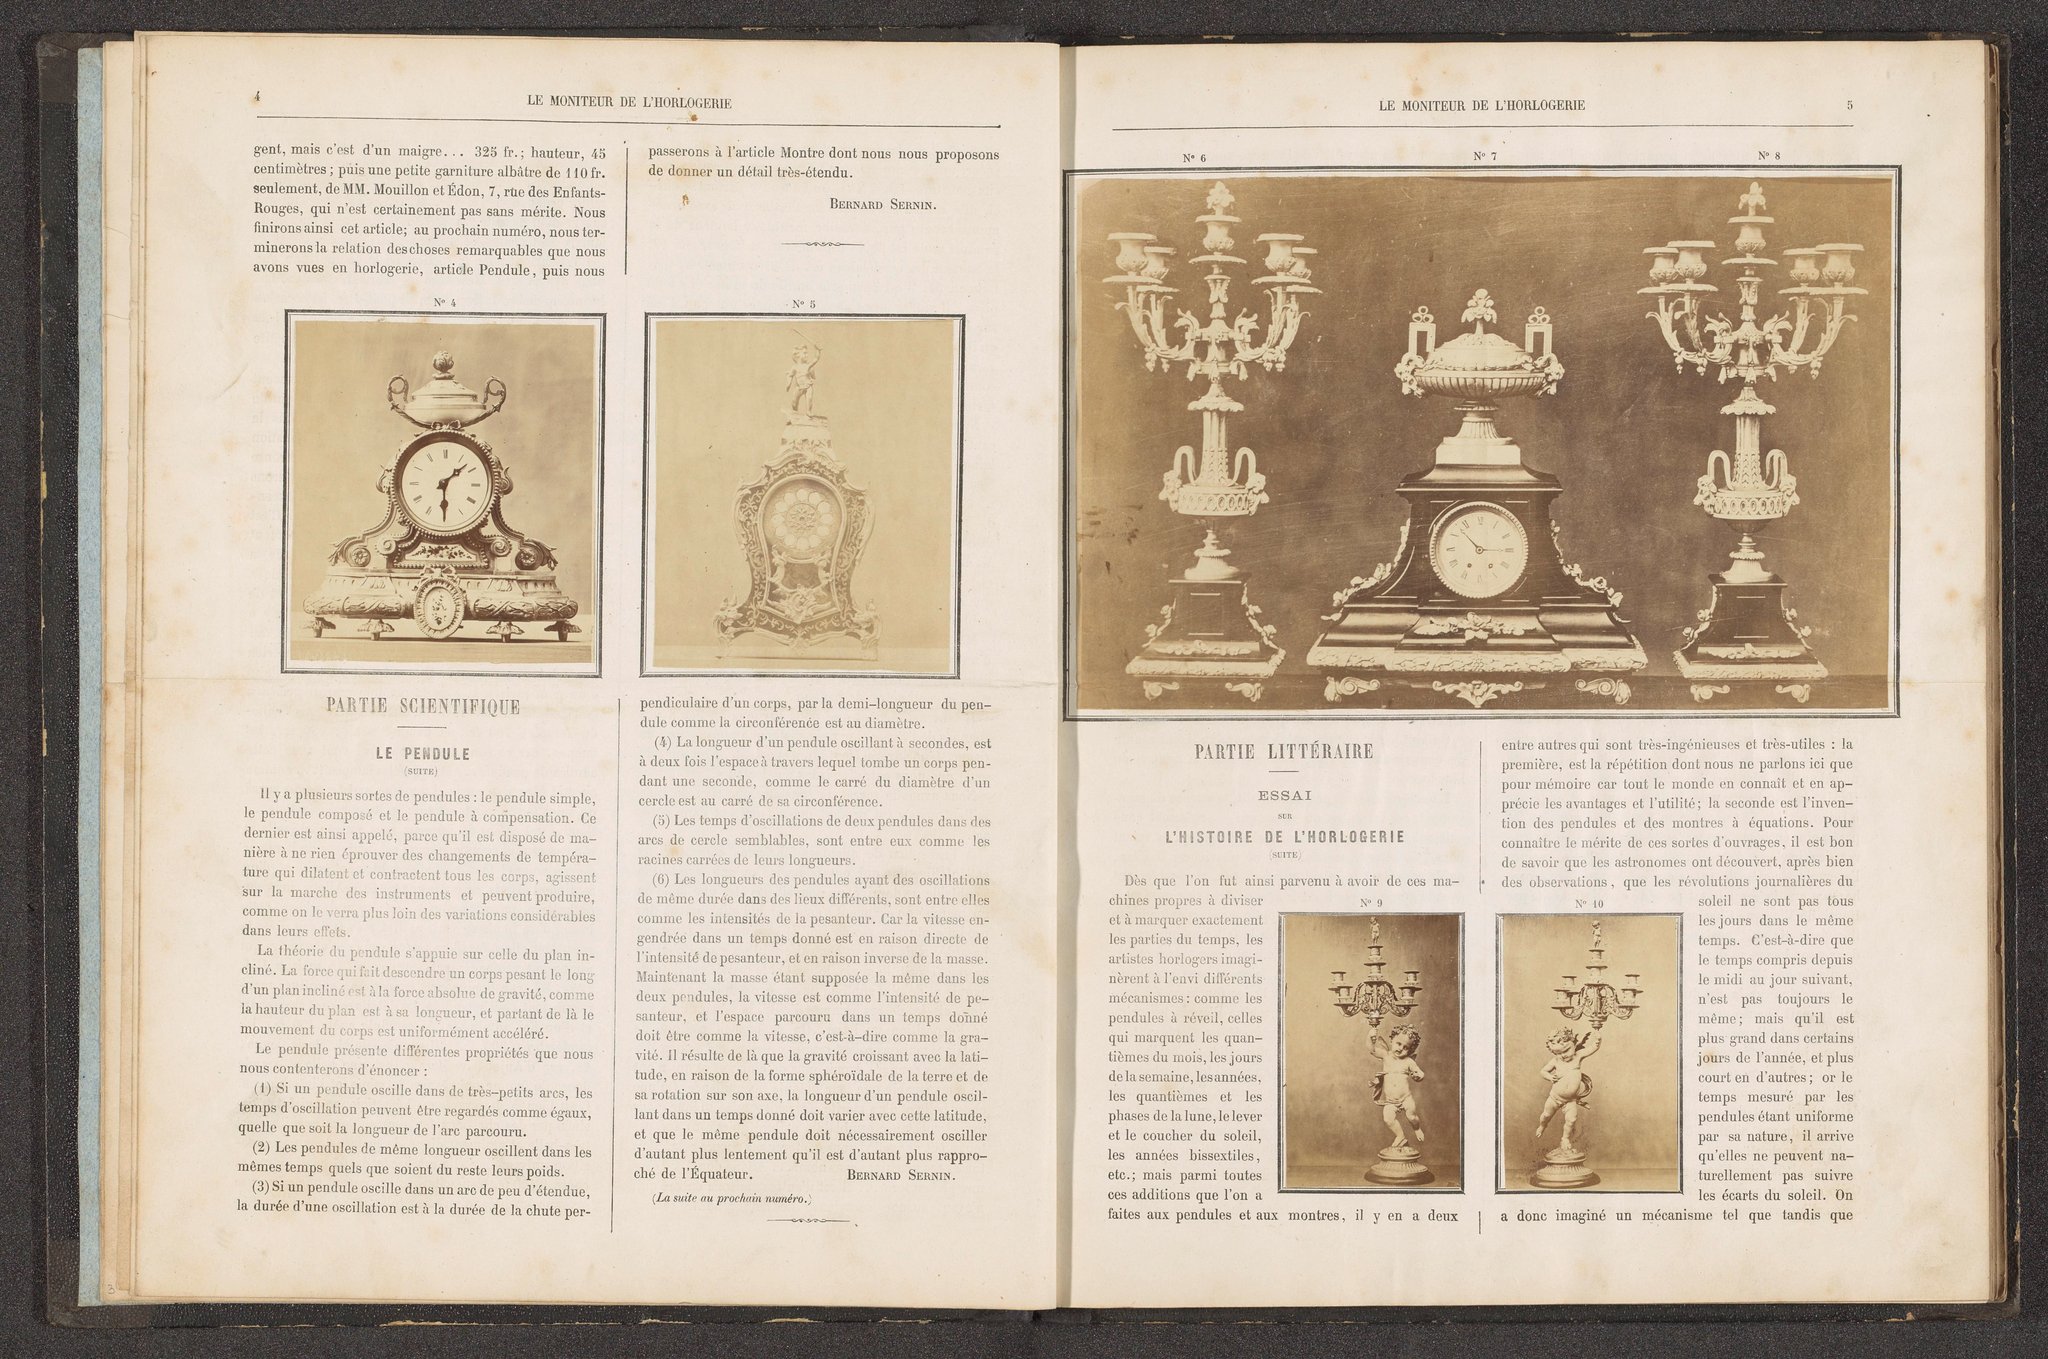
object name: page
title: Twee klokken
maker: Anonymous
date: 1857-1867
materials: photographic support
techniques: albumen print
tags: clock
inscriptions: number: ‘No 4 No 5’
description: Links: door M. Heinrich, rechts: door M. Dhénain.